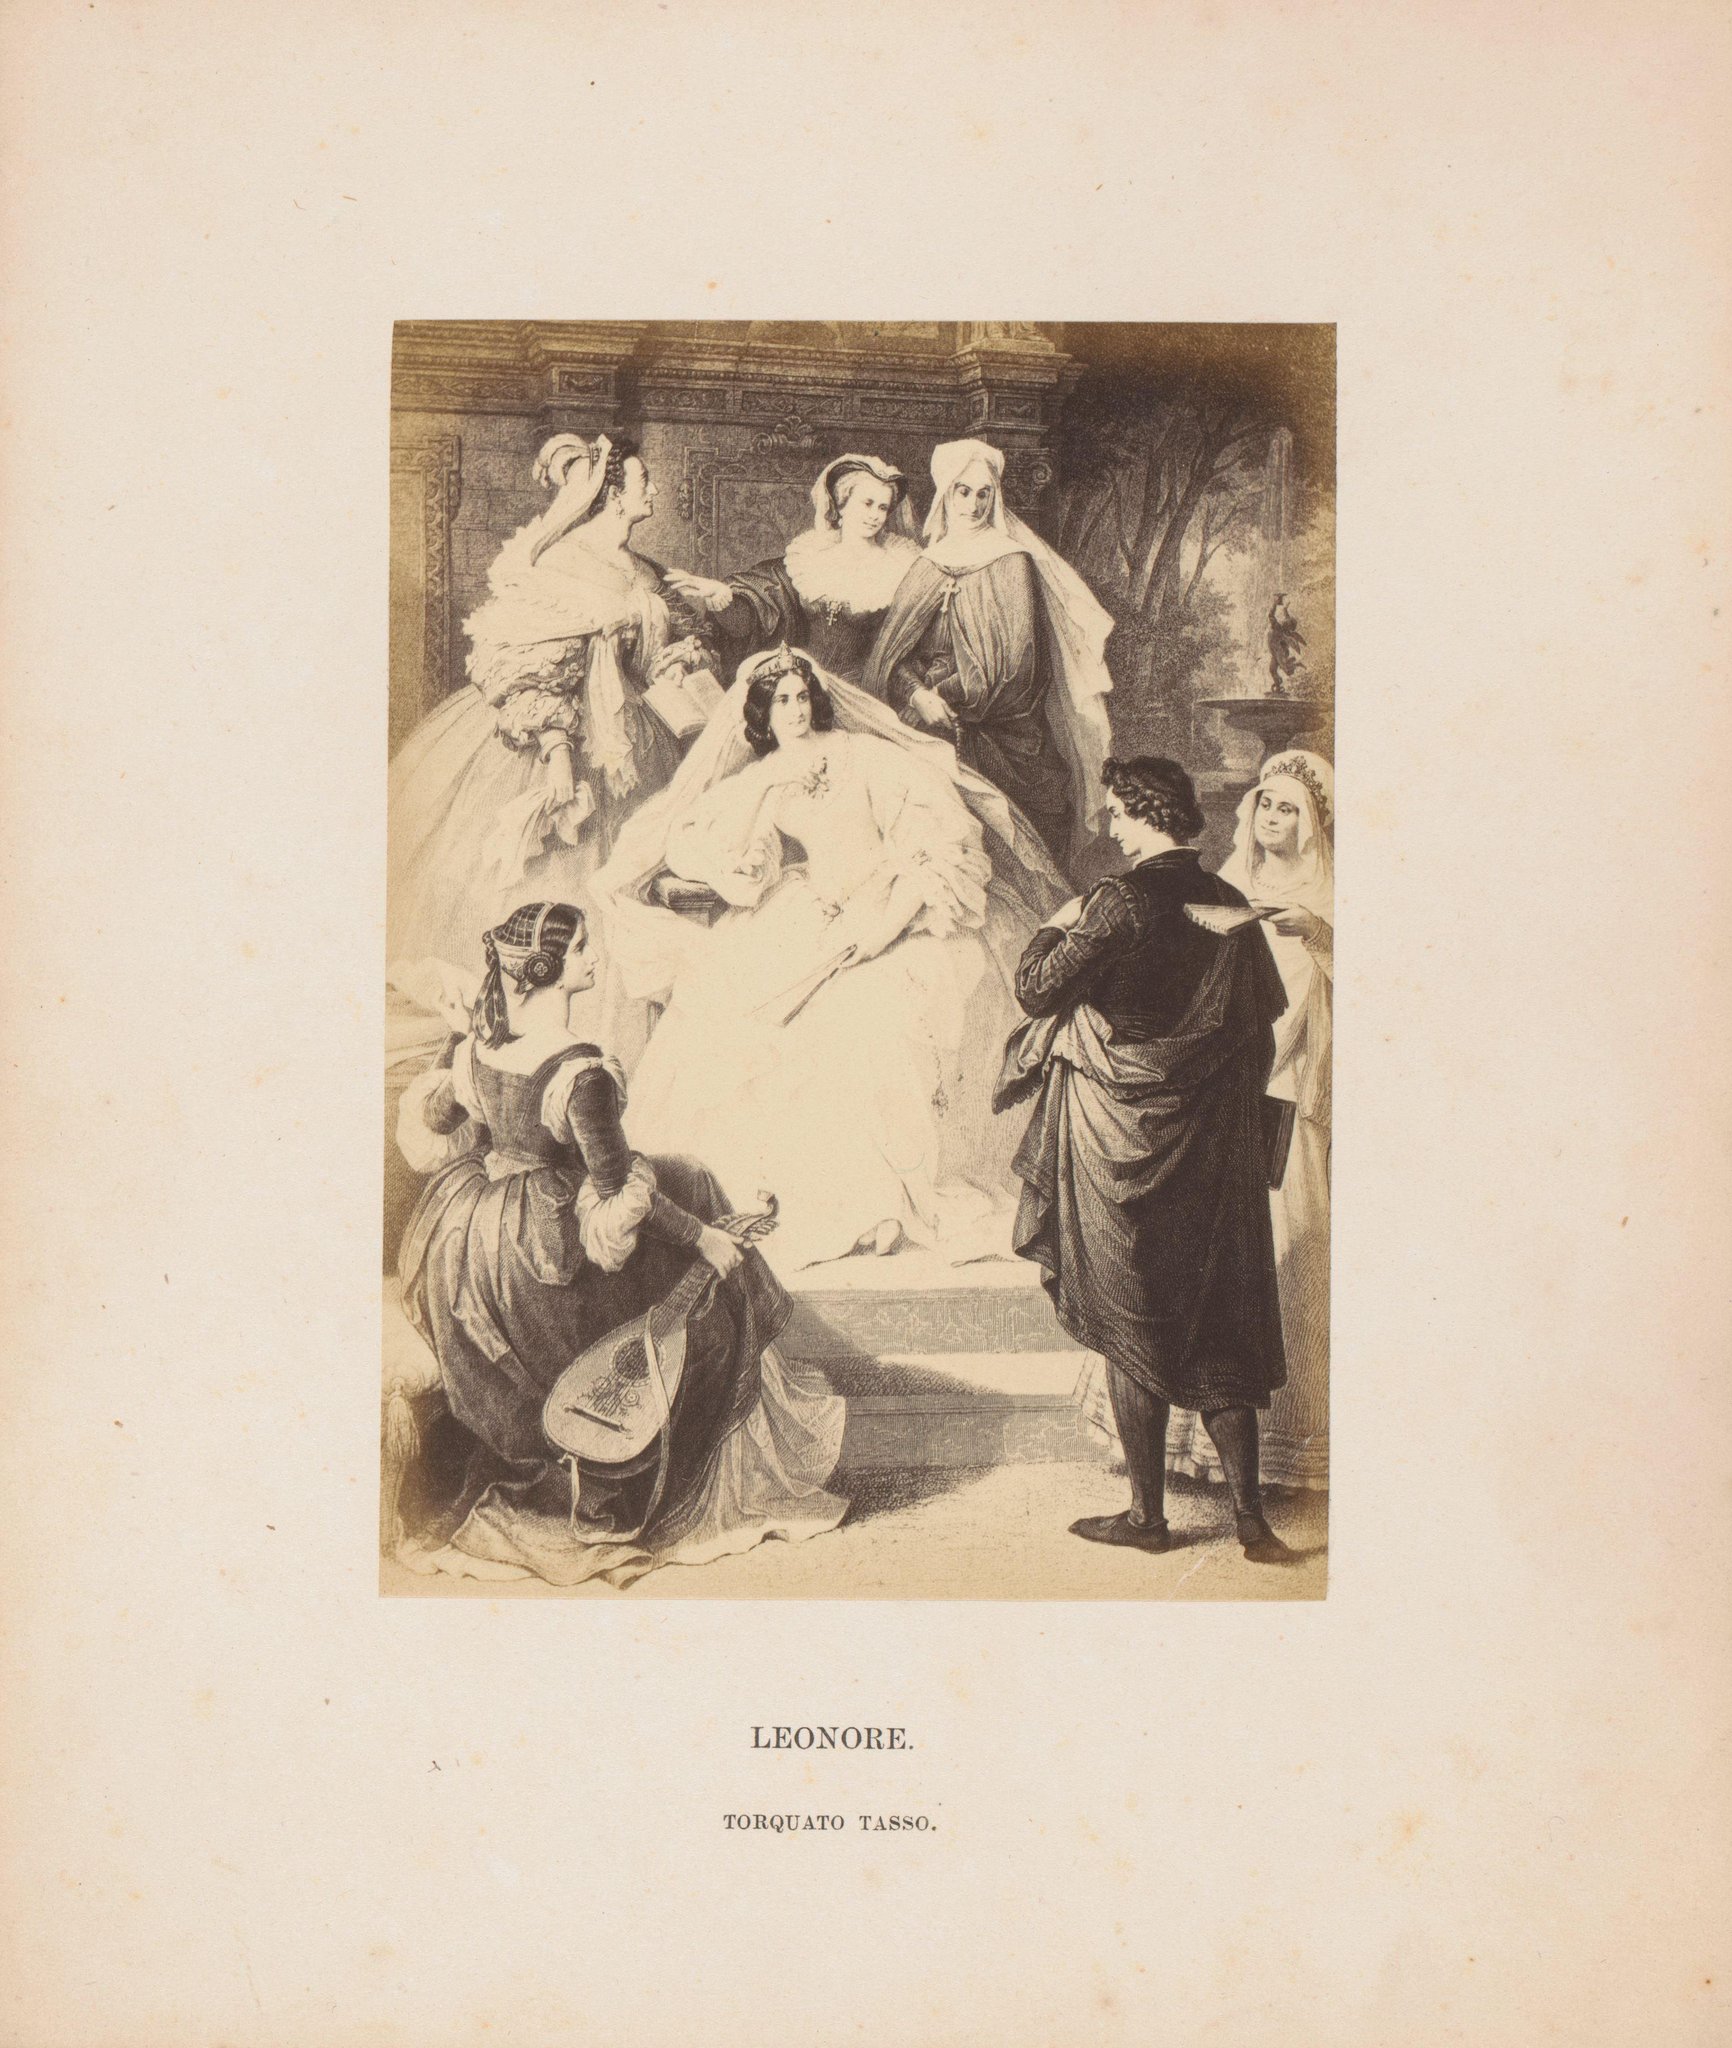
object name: reproduction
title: Fotoreproductie van een tekening van Leonore uit Goethe's Torquato Tasso door Wilhelm von Kaulbach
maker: Anonymous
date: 1850-1900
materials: cardboard, photographic support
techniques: albumen print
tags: adult man, adult woman (+ six persons), specific works of literature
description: Deze foto maakt deel uit van een omslag met 22 foto's.